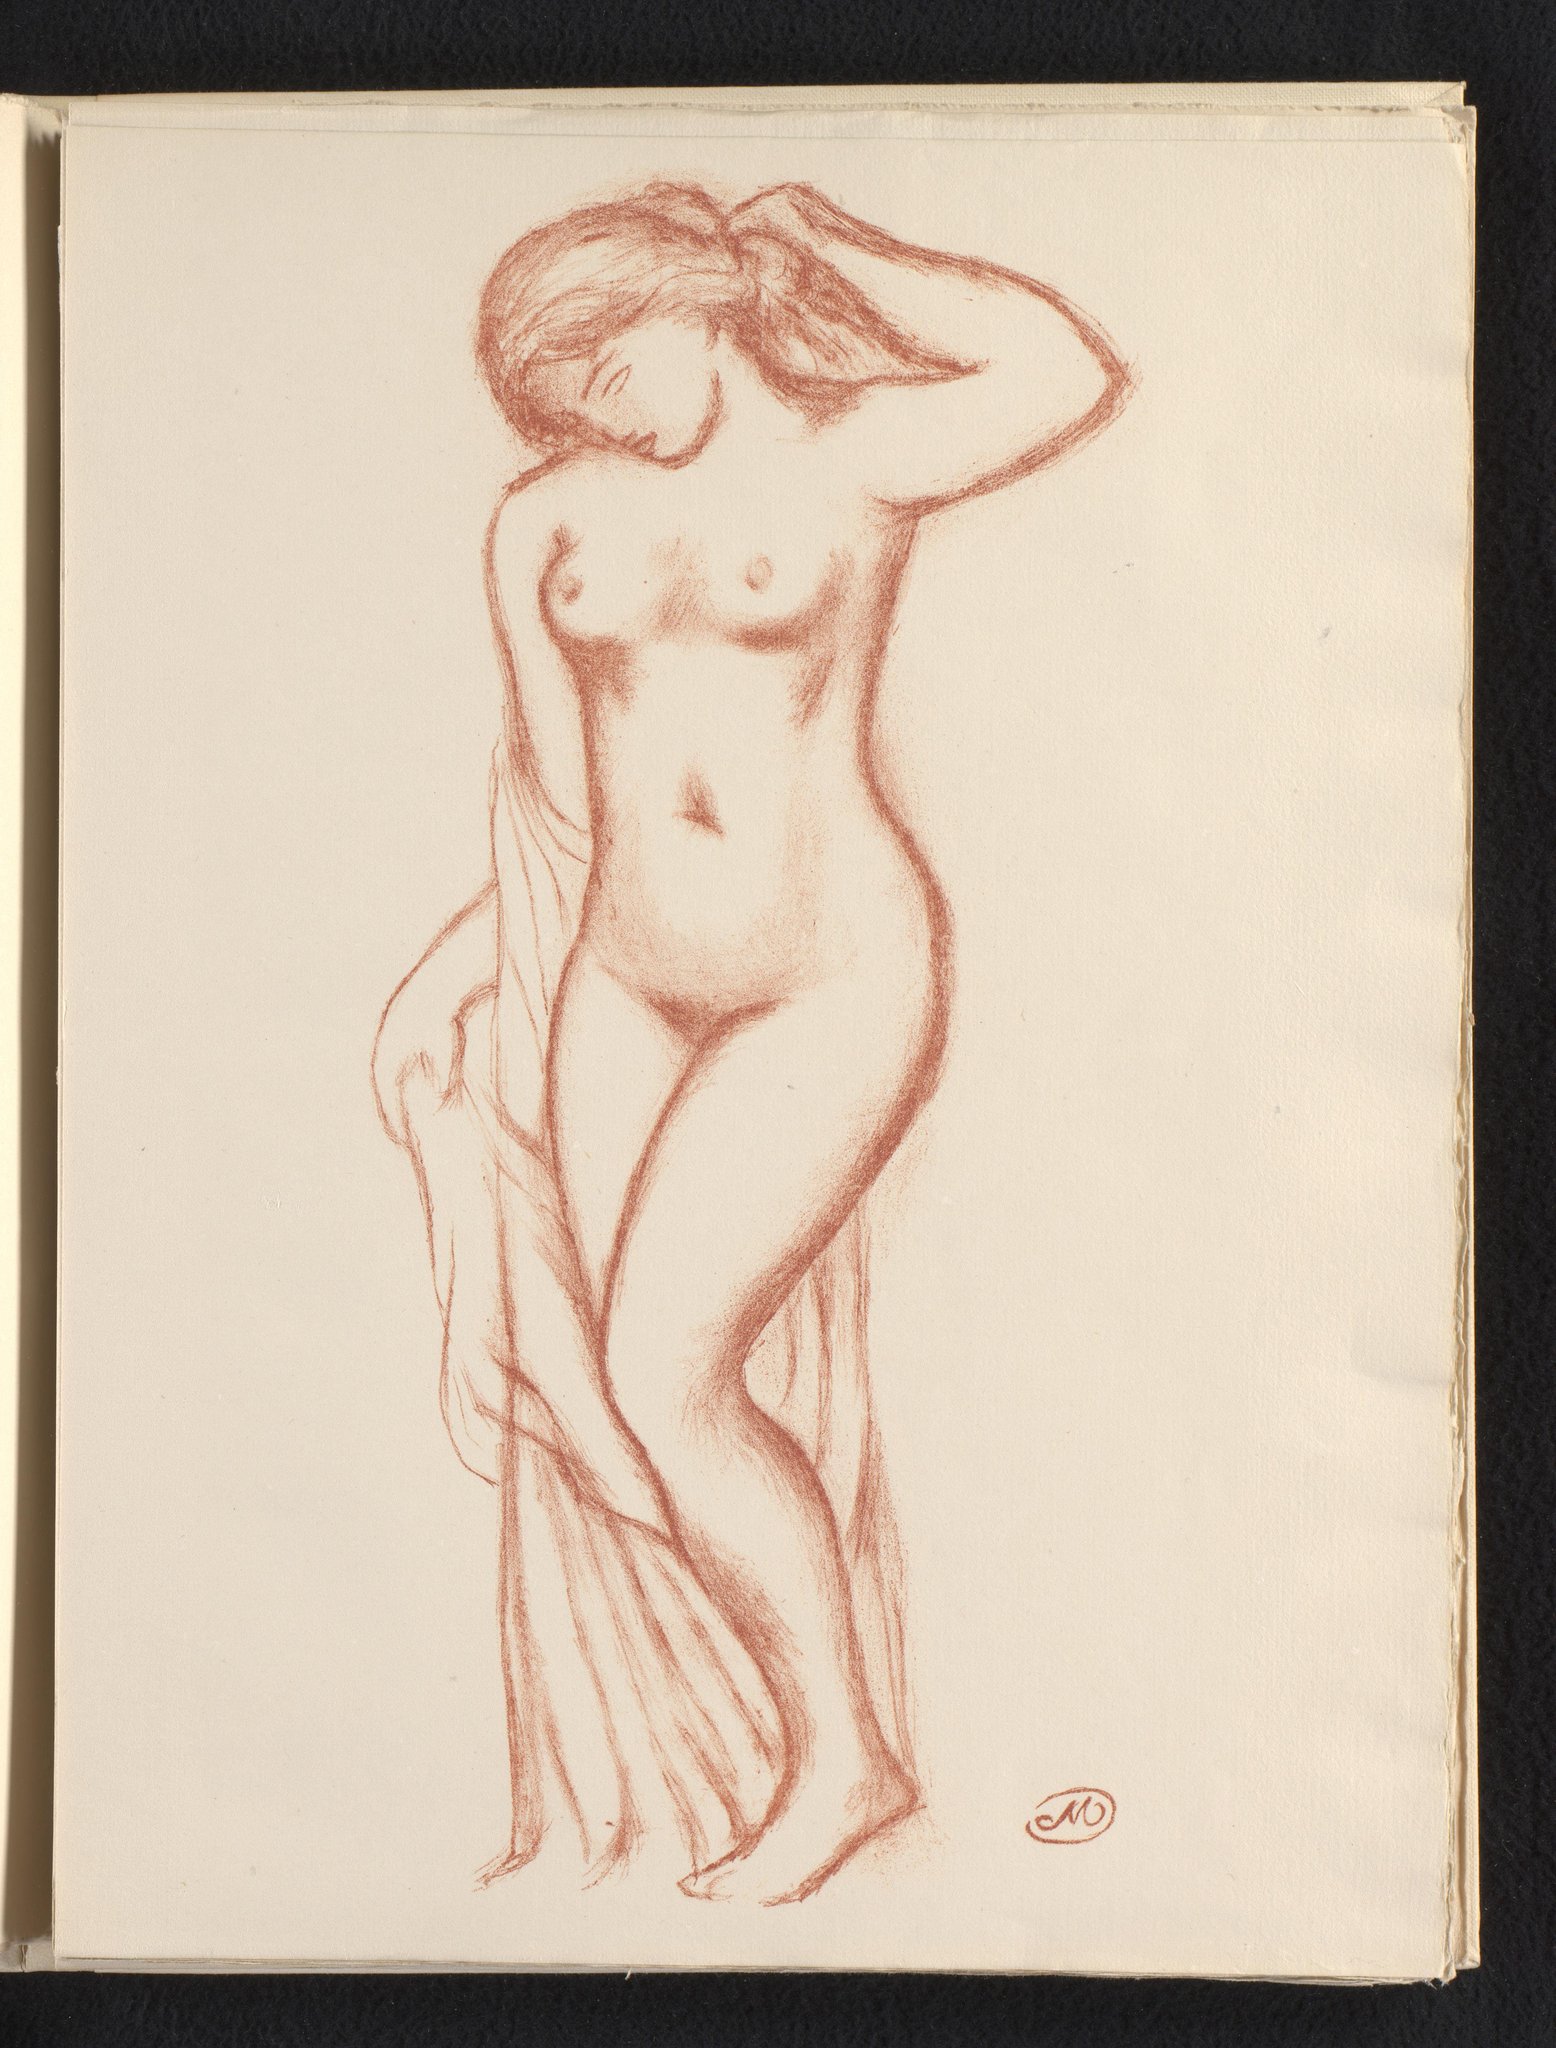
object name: print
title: Staande naakte vrouw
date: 1948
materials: paper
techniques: lithograph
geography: paris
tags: woman (showing herself) undressed, quasi-nude, standing figure - aa - female human figure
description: Prent uit: Lucianus van Samosata. Dialogues des Courtisanes. [Vertaald uit het Grieks door] Charles Astruc. Parijs: s.n., 1948, deel van de suite met een extra afdruk van de prenten in sanguine.